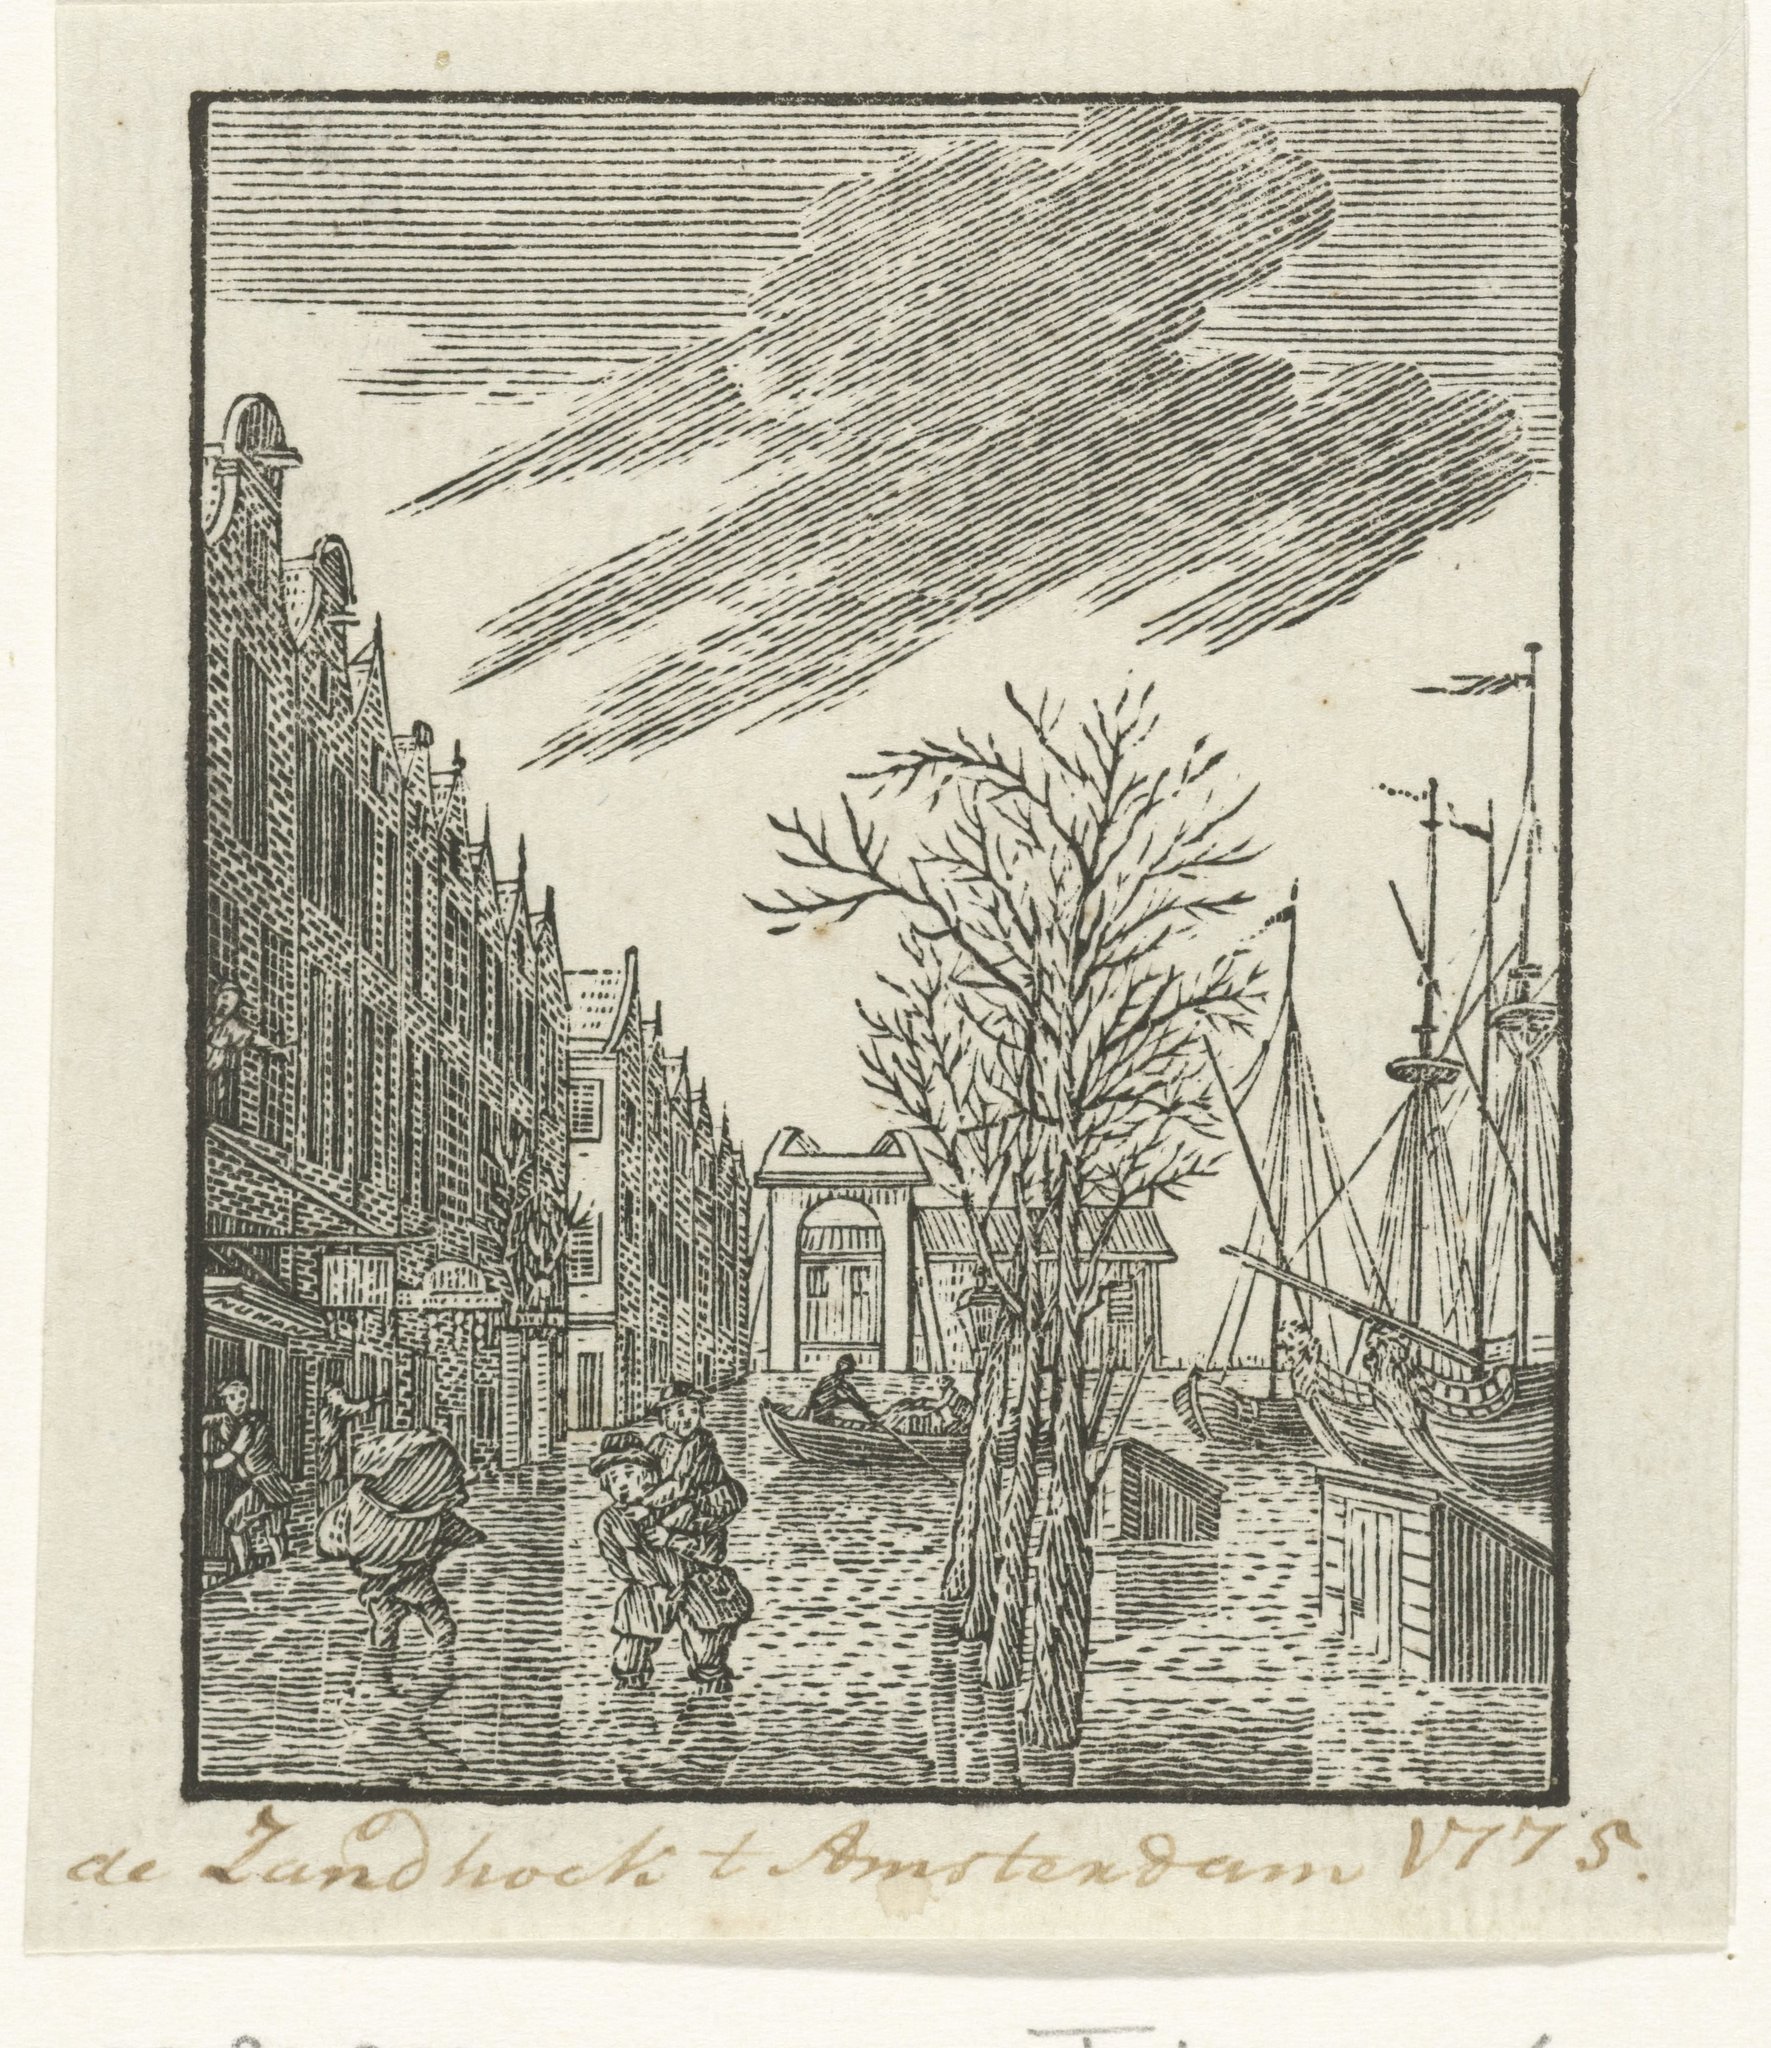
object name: print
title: Overstroming bij de Zandhoek te Amsterdam, 1775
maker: hendrik numan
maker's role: draughtsman, print maker, publisher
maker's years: 1736-1788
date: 1775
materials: paper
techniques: woodcut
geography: northern netherlands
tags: dike-break, the flood of 14-18 november 1775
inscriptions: collector's mark: Lugt 2228, inscription: ‘de Zandhoek te Amsterdam 1775.’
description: Overstroomde straten van de Zandhoek te Amsterdam, na de storm op 15 november 1775.